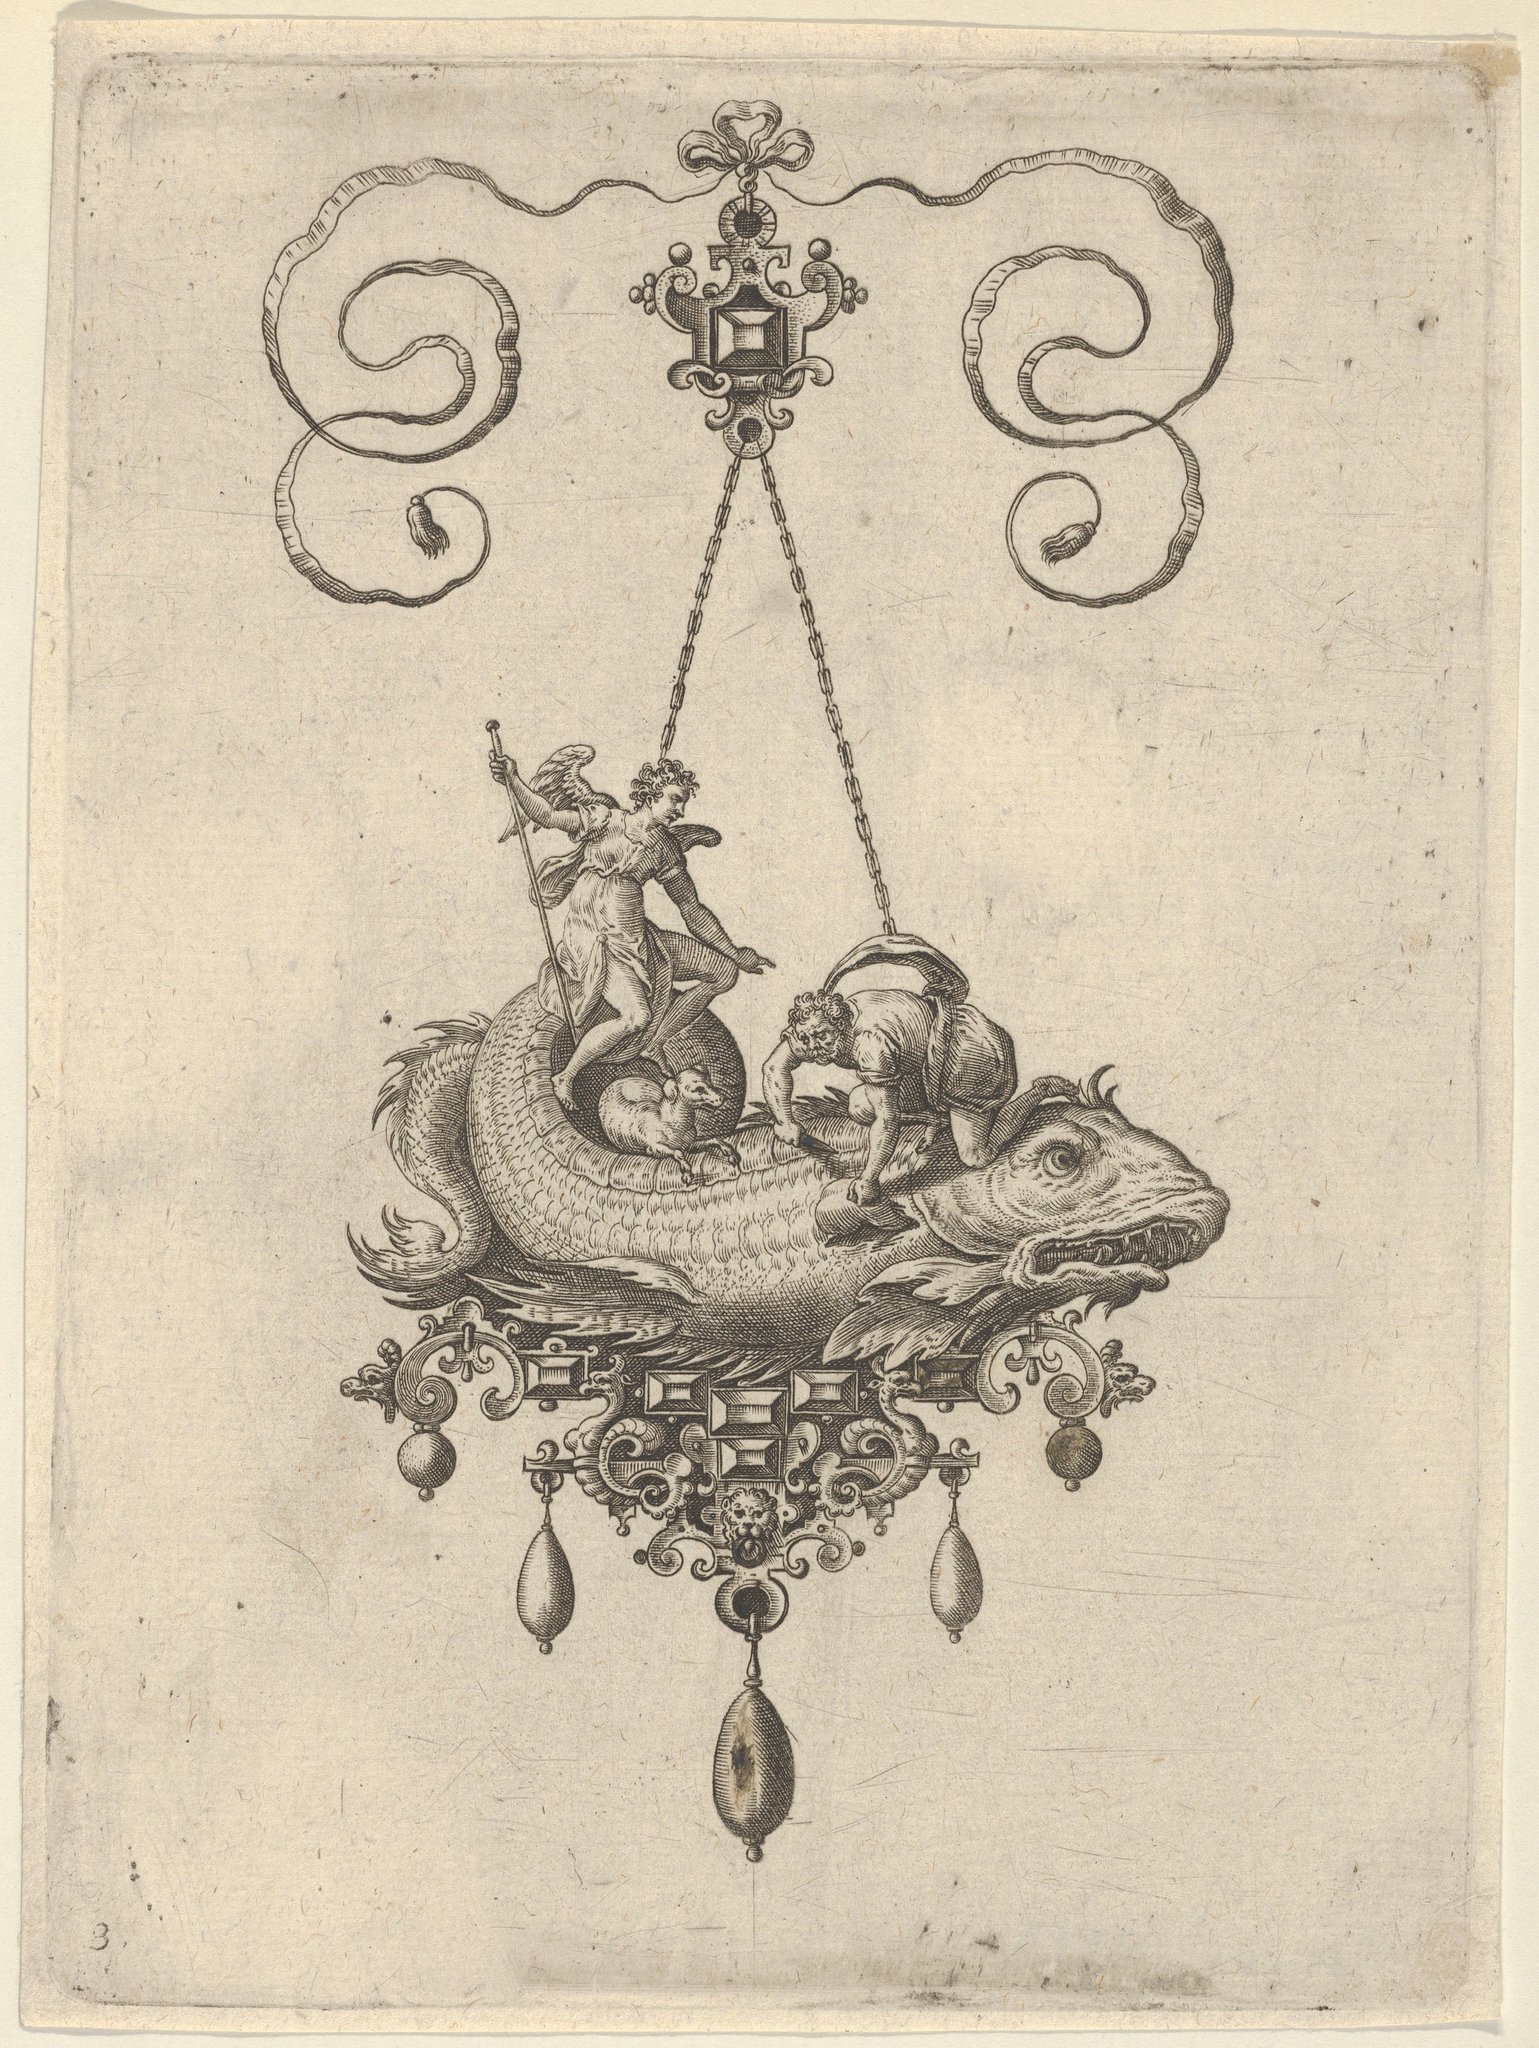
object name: print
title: Pendant Design with a Fish Carrying Tobias and the Angel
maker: adriaen collaert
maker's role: artist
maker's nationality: netherlandish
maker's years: 1560-1618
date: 1582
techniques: engraving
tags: pendants,dogs,fish